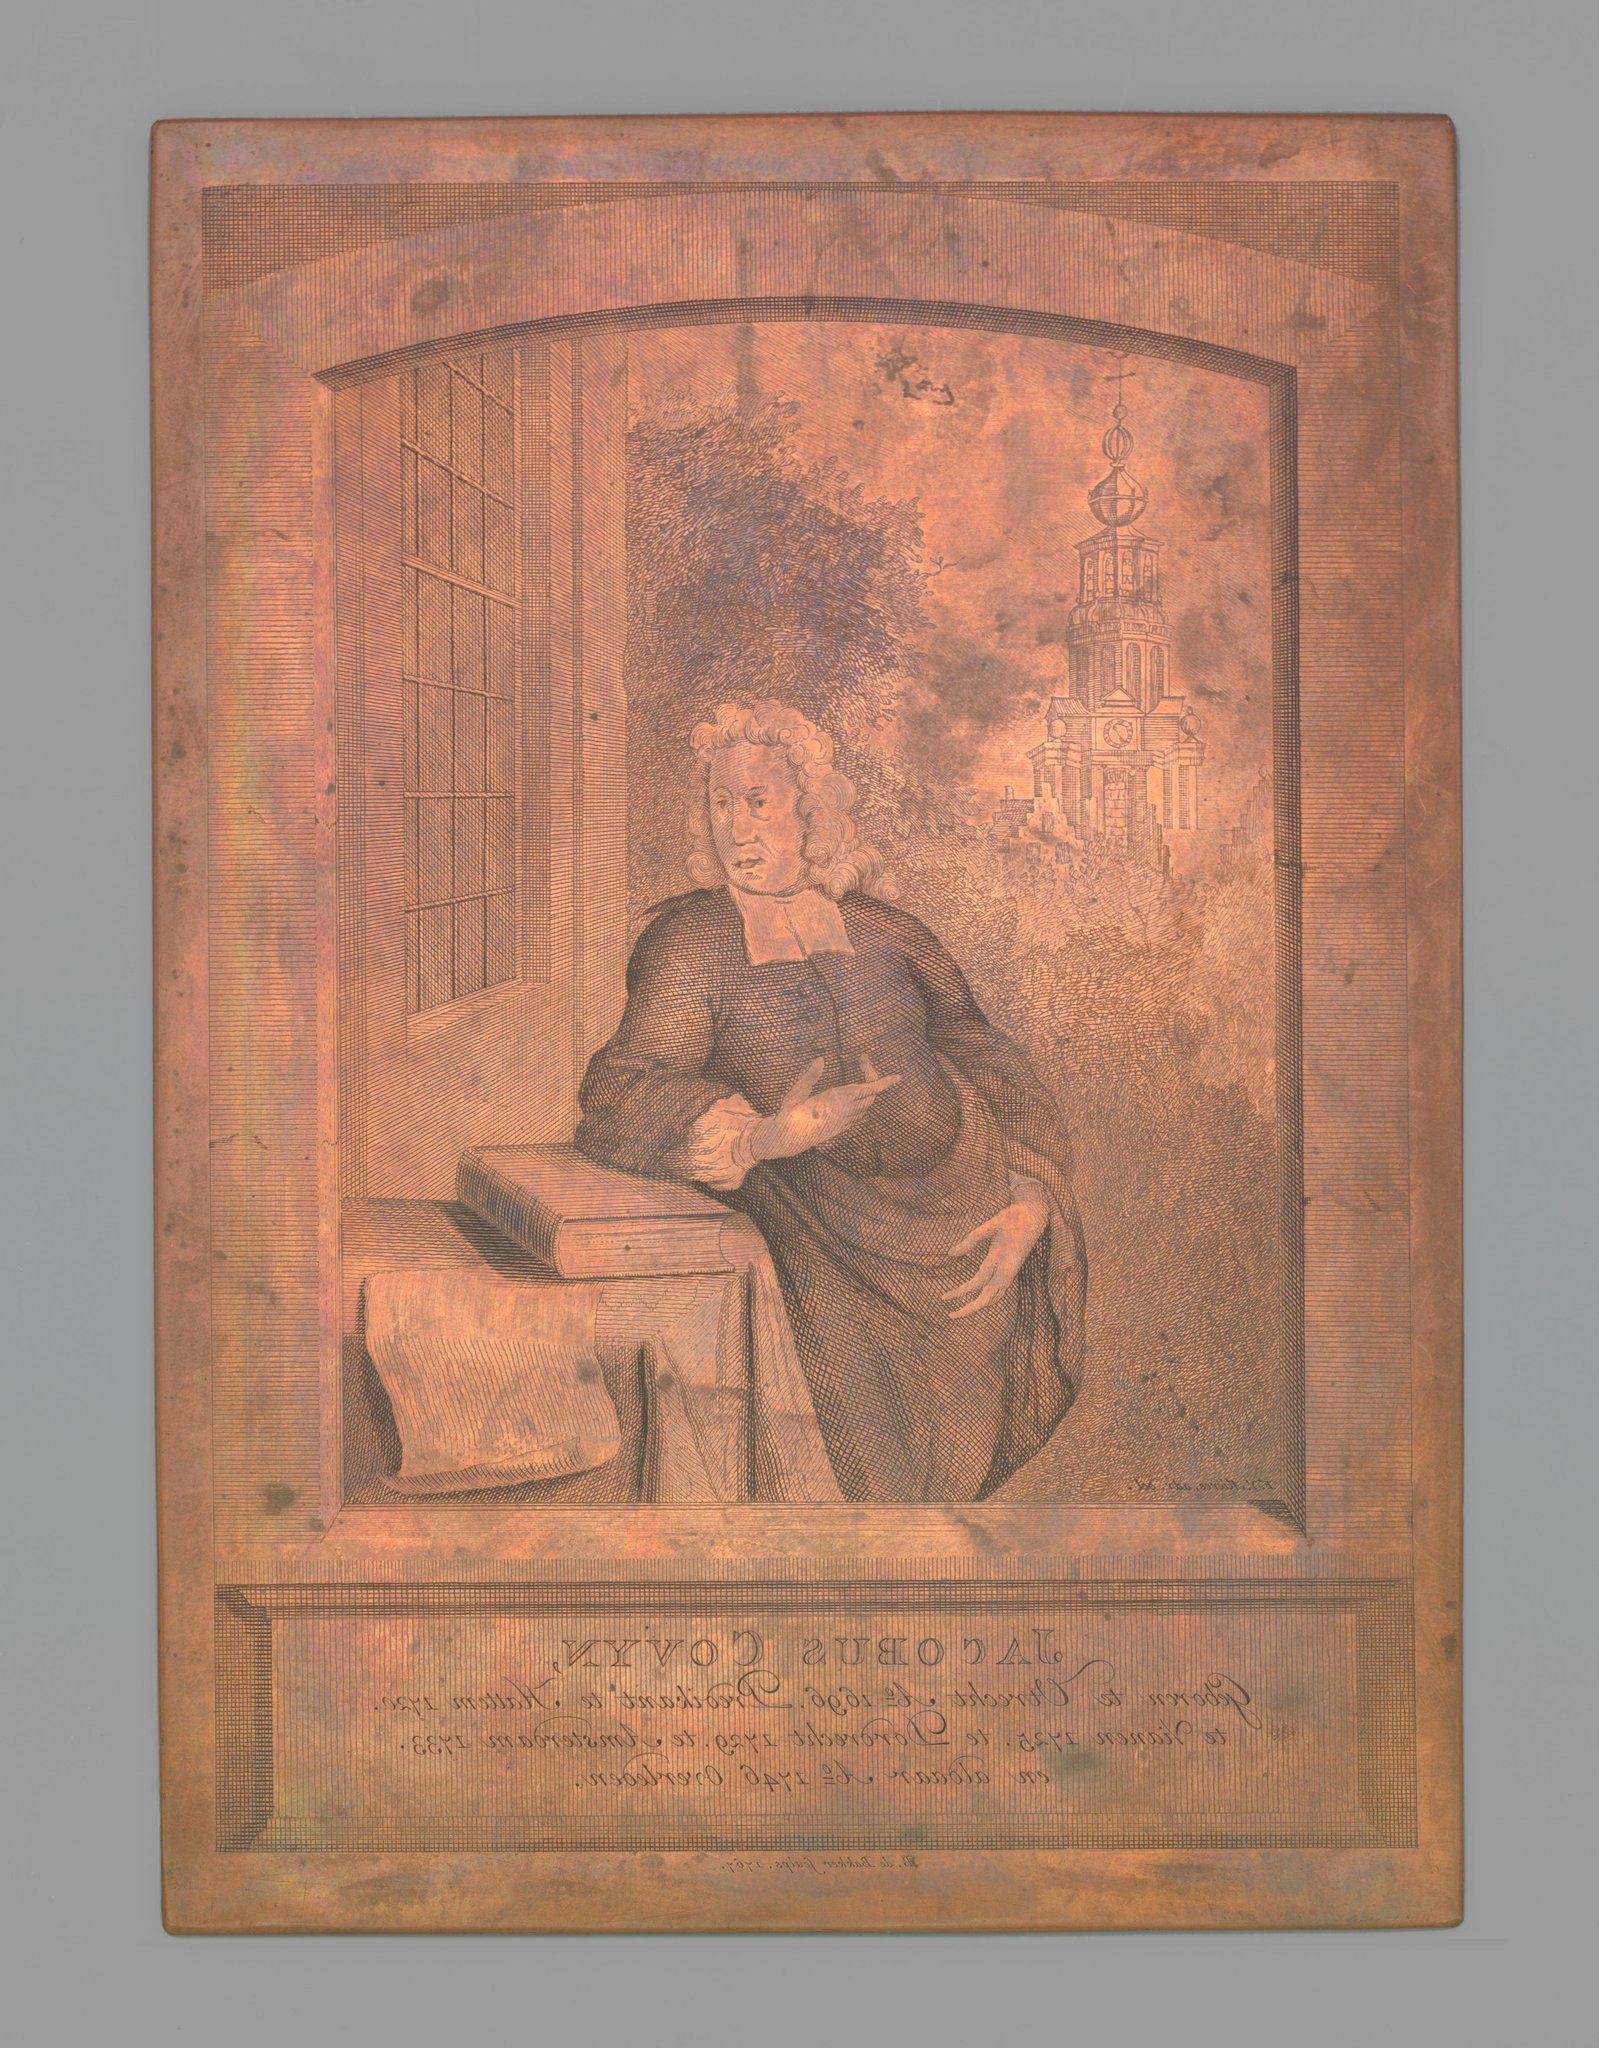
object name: copper plate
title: Portret van Jacobus Covijn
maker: barent de bakker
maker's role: print maker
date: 1767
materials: copper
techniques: engraving